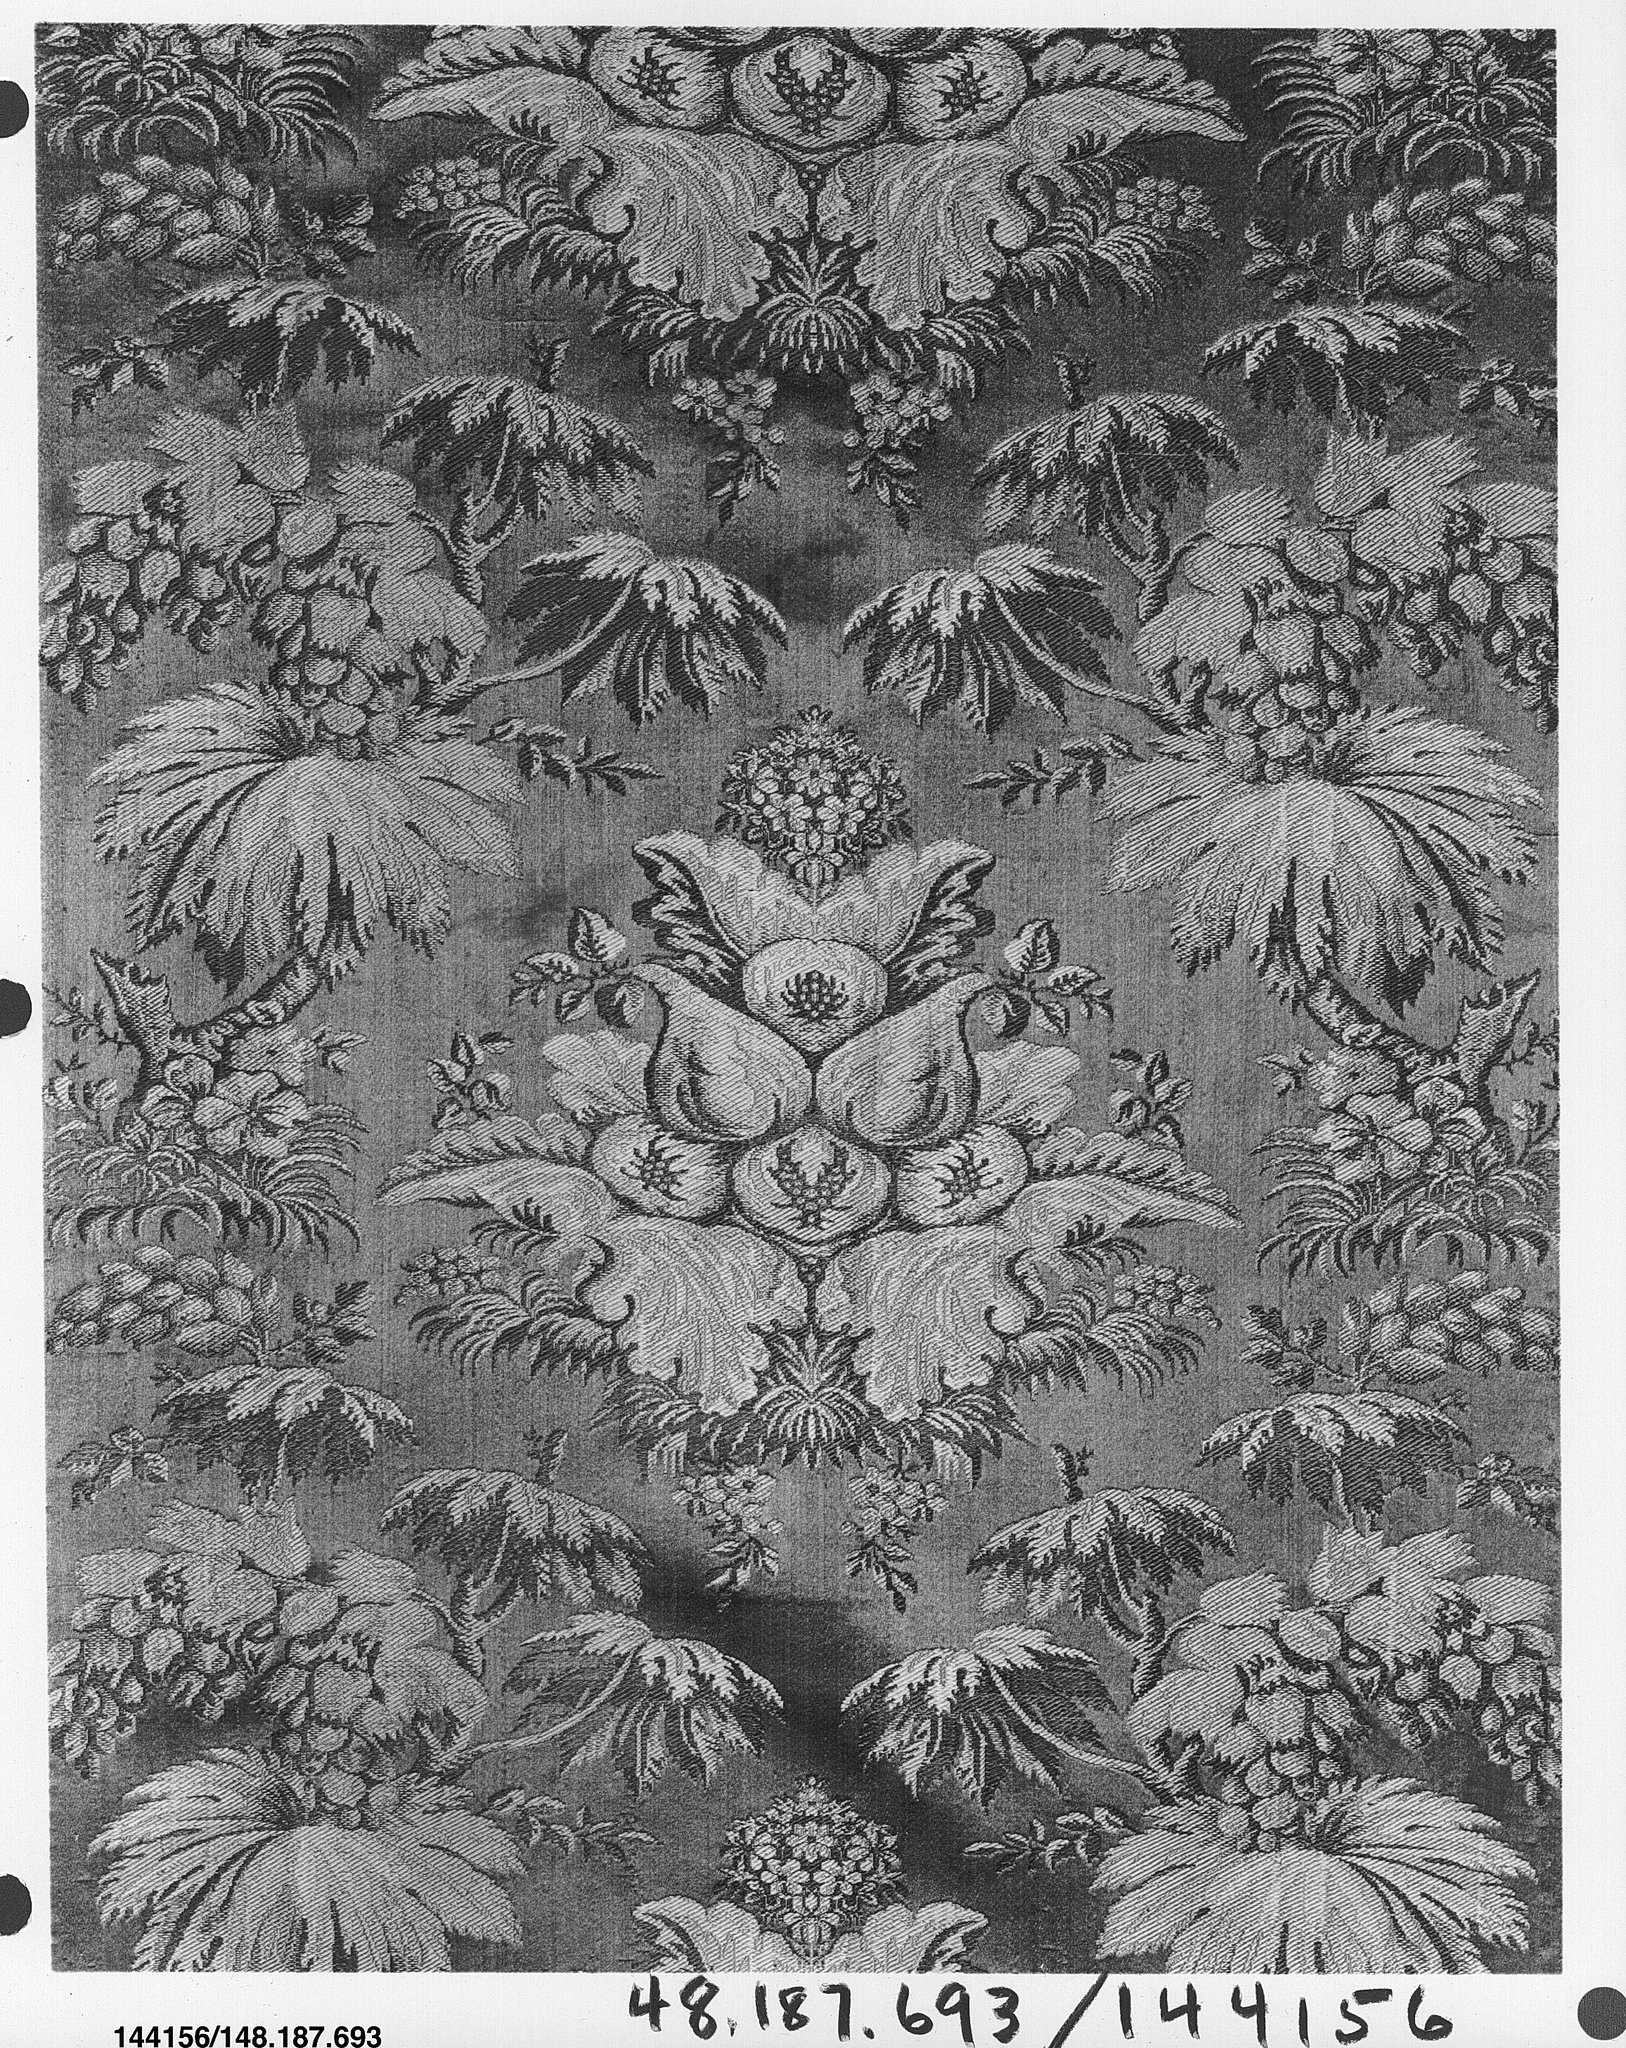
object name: piece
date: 1735-1740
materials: silk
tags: flowers,leaves